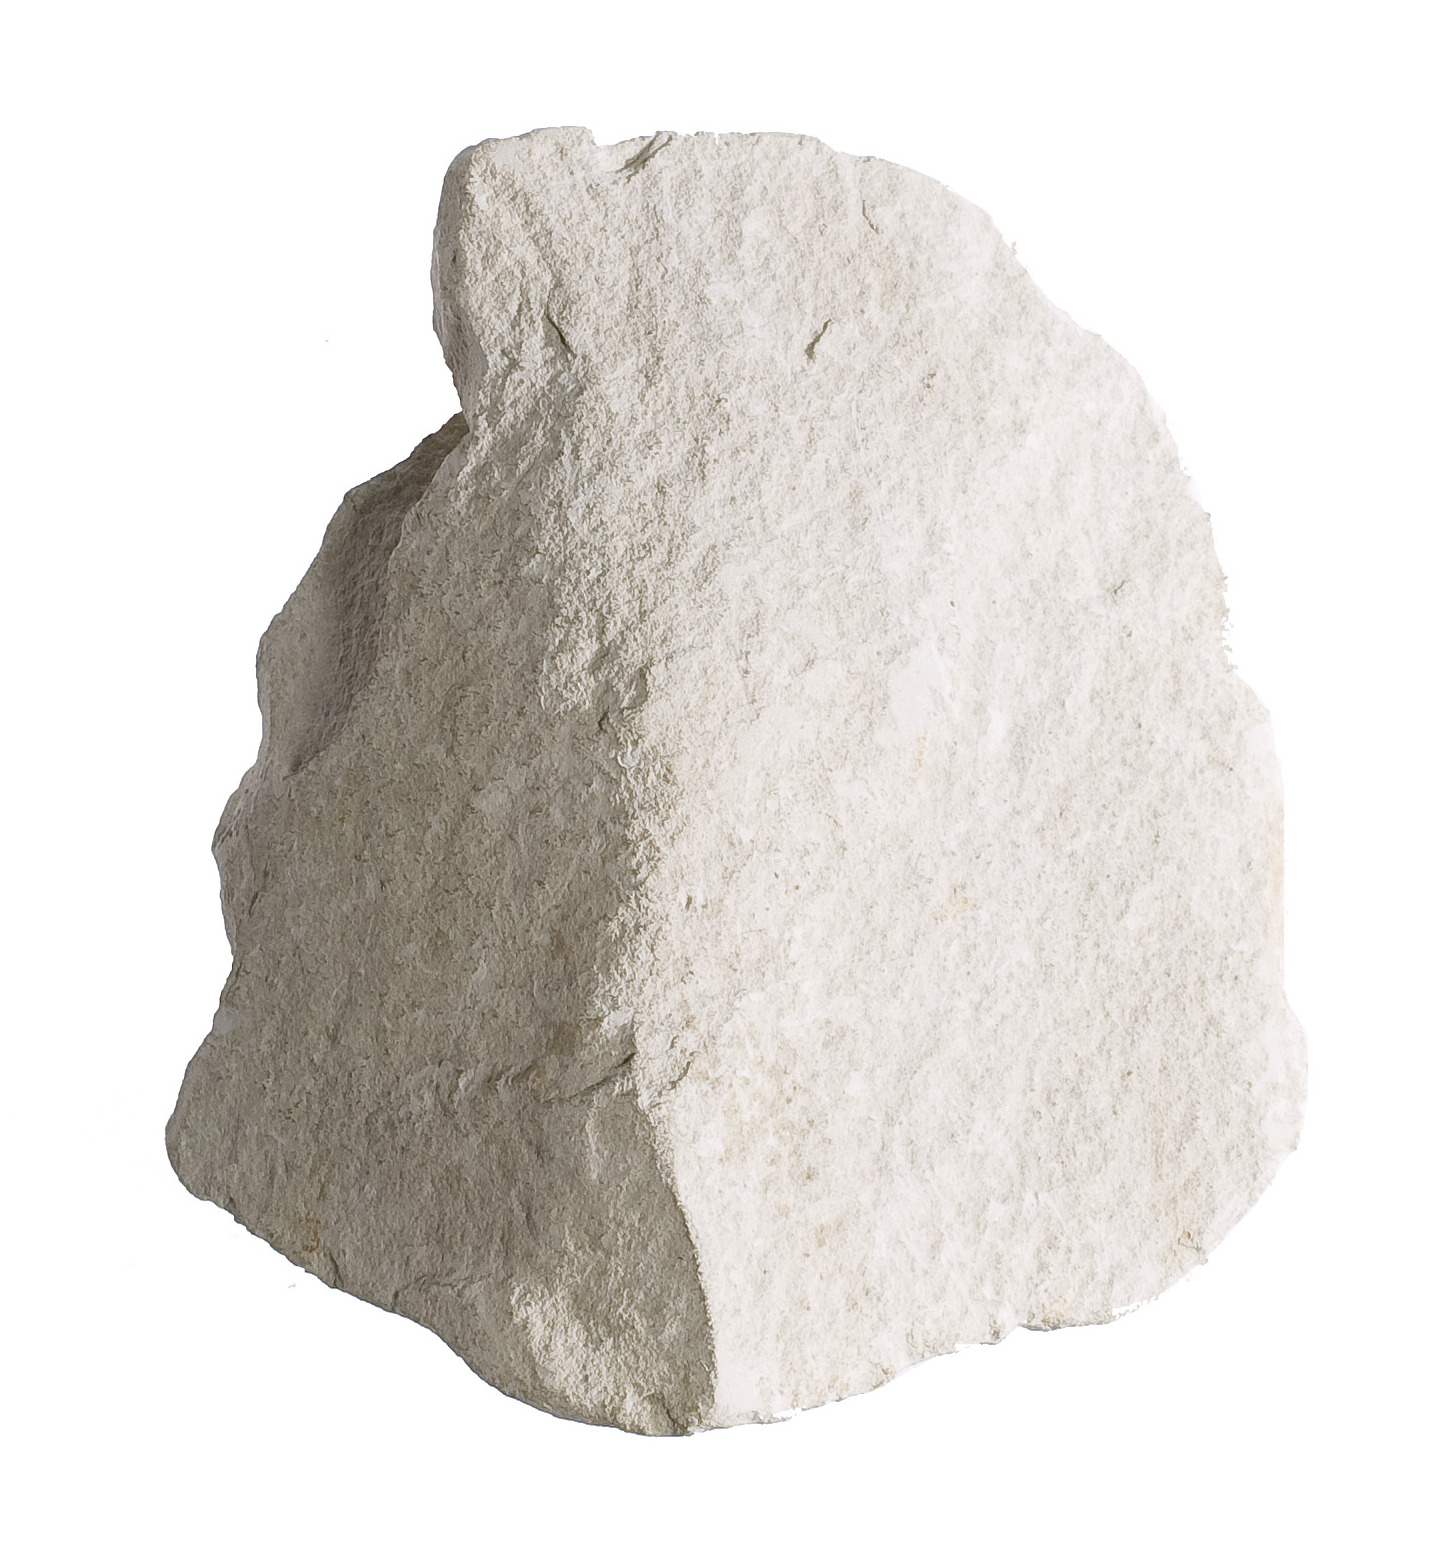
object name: fragment, gypsum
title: fragment of gypsum from foundations?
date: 1353-1336 BCE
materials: gypsum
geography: egypt